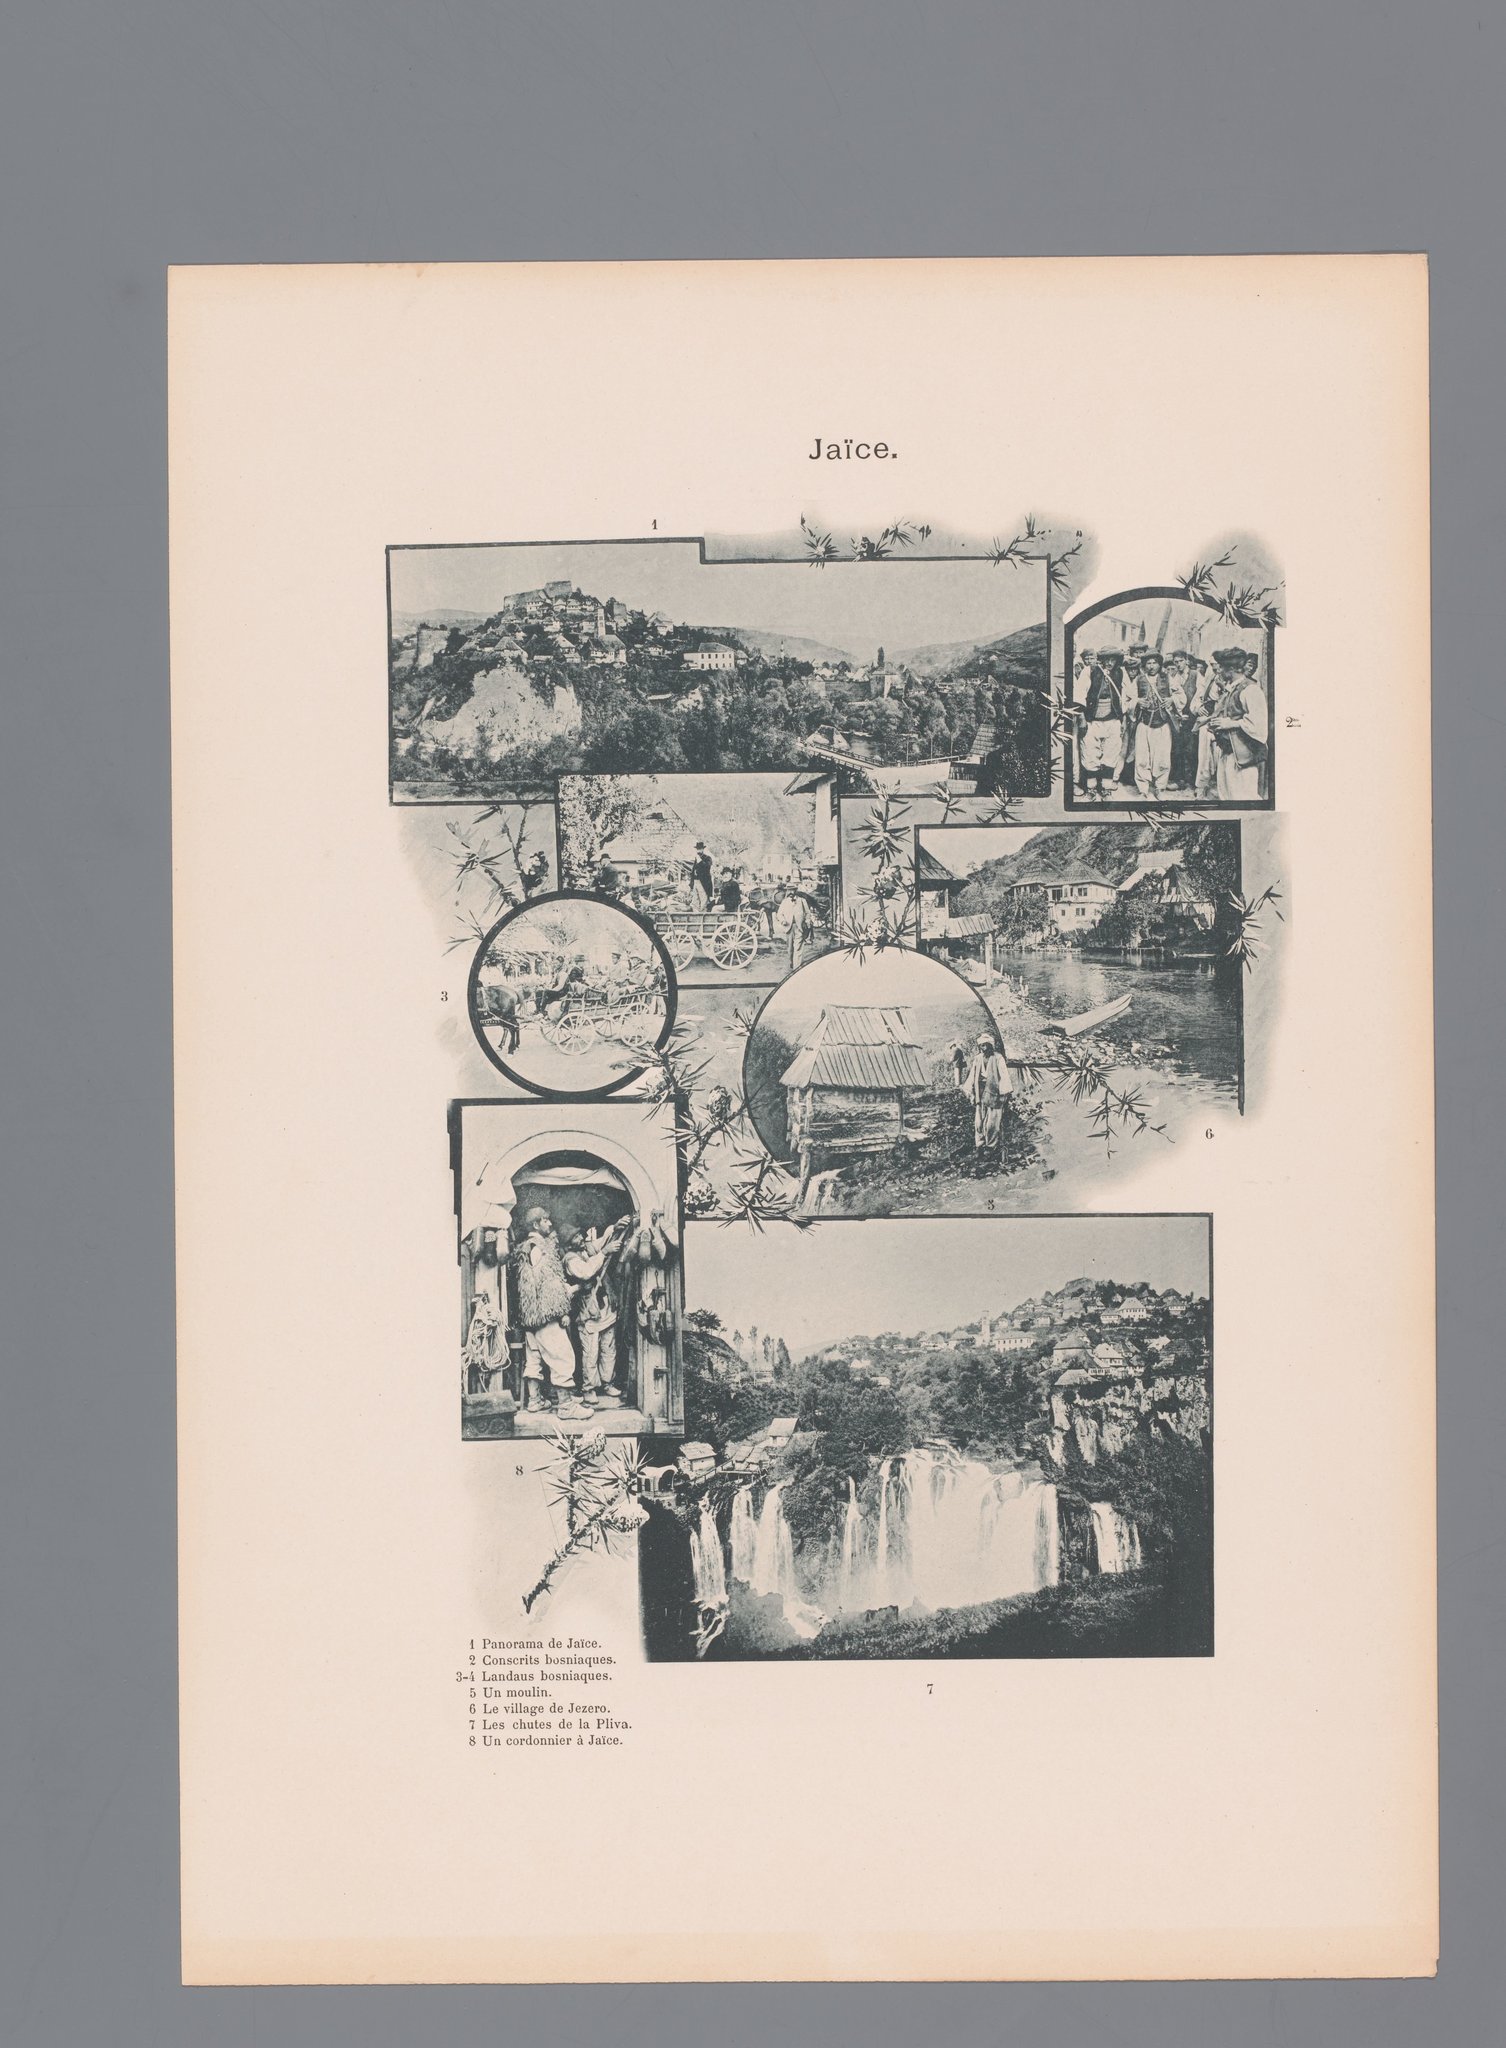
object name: photomechanical print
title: Jaïce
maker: Anonymous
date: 1893-1898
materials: paper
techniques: photograph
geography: jajce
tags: adult man (+ more than eight persons), prospect of city, town panorama, silhouette of city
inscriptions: inscription: ‘1 Panorama de Jaïce./ 2 Conscrits bosniaques./ 3-4 Landaus bosniaques./ 5 Un moulin./ 6 Le village de Jezero./ 7 Les chutes de la Pliva./ 8 Un cordonnier à Jaïce.’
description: Deze prenten maken deel uit van een omslag met 103 prenten op 16 bladen en een titelblad.